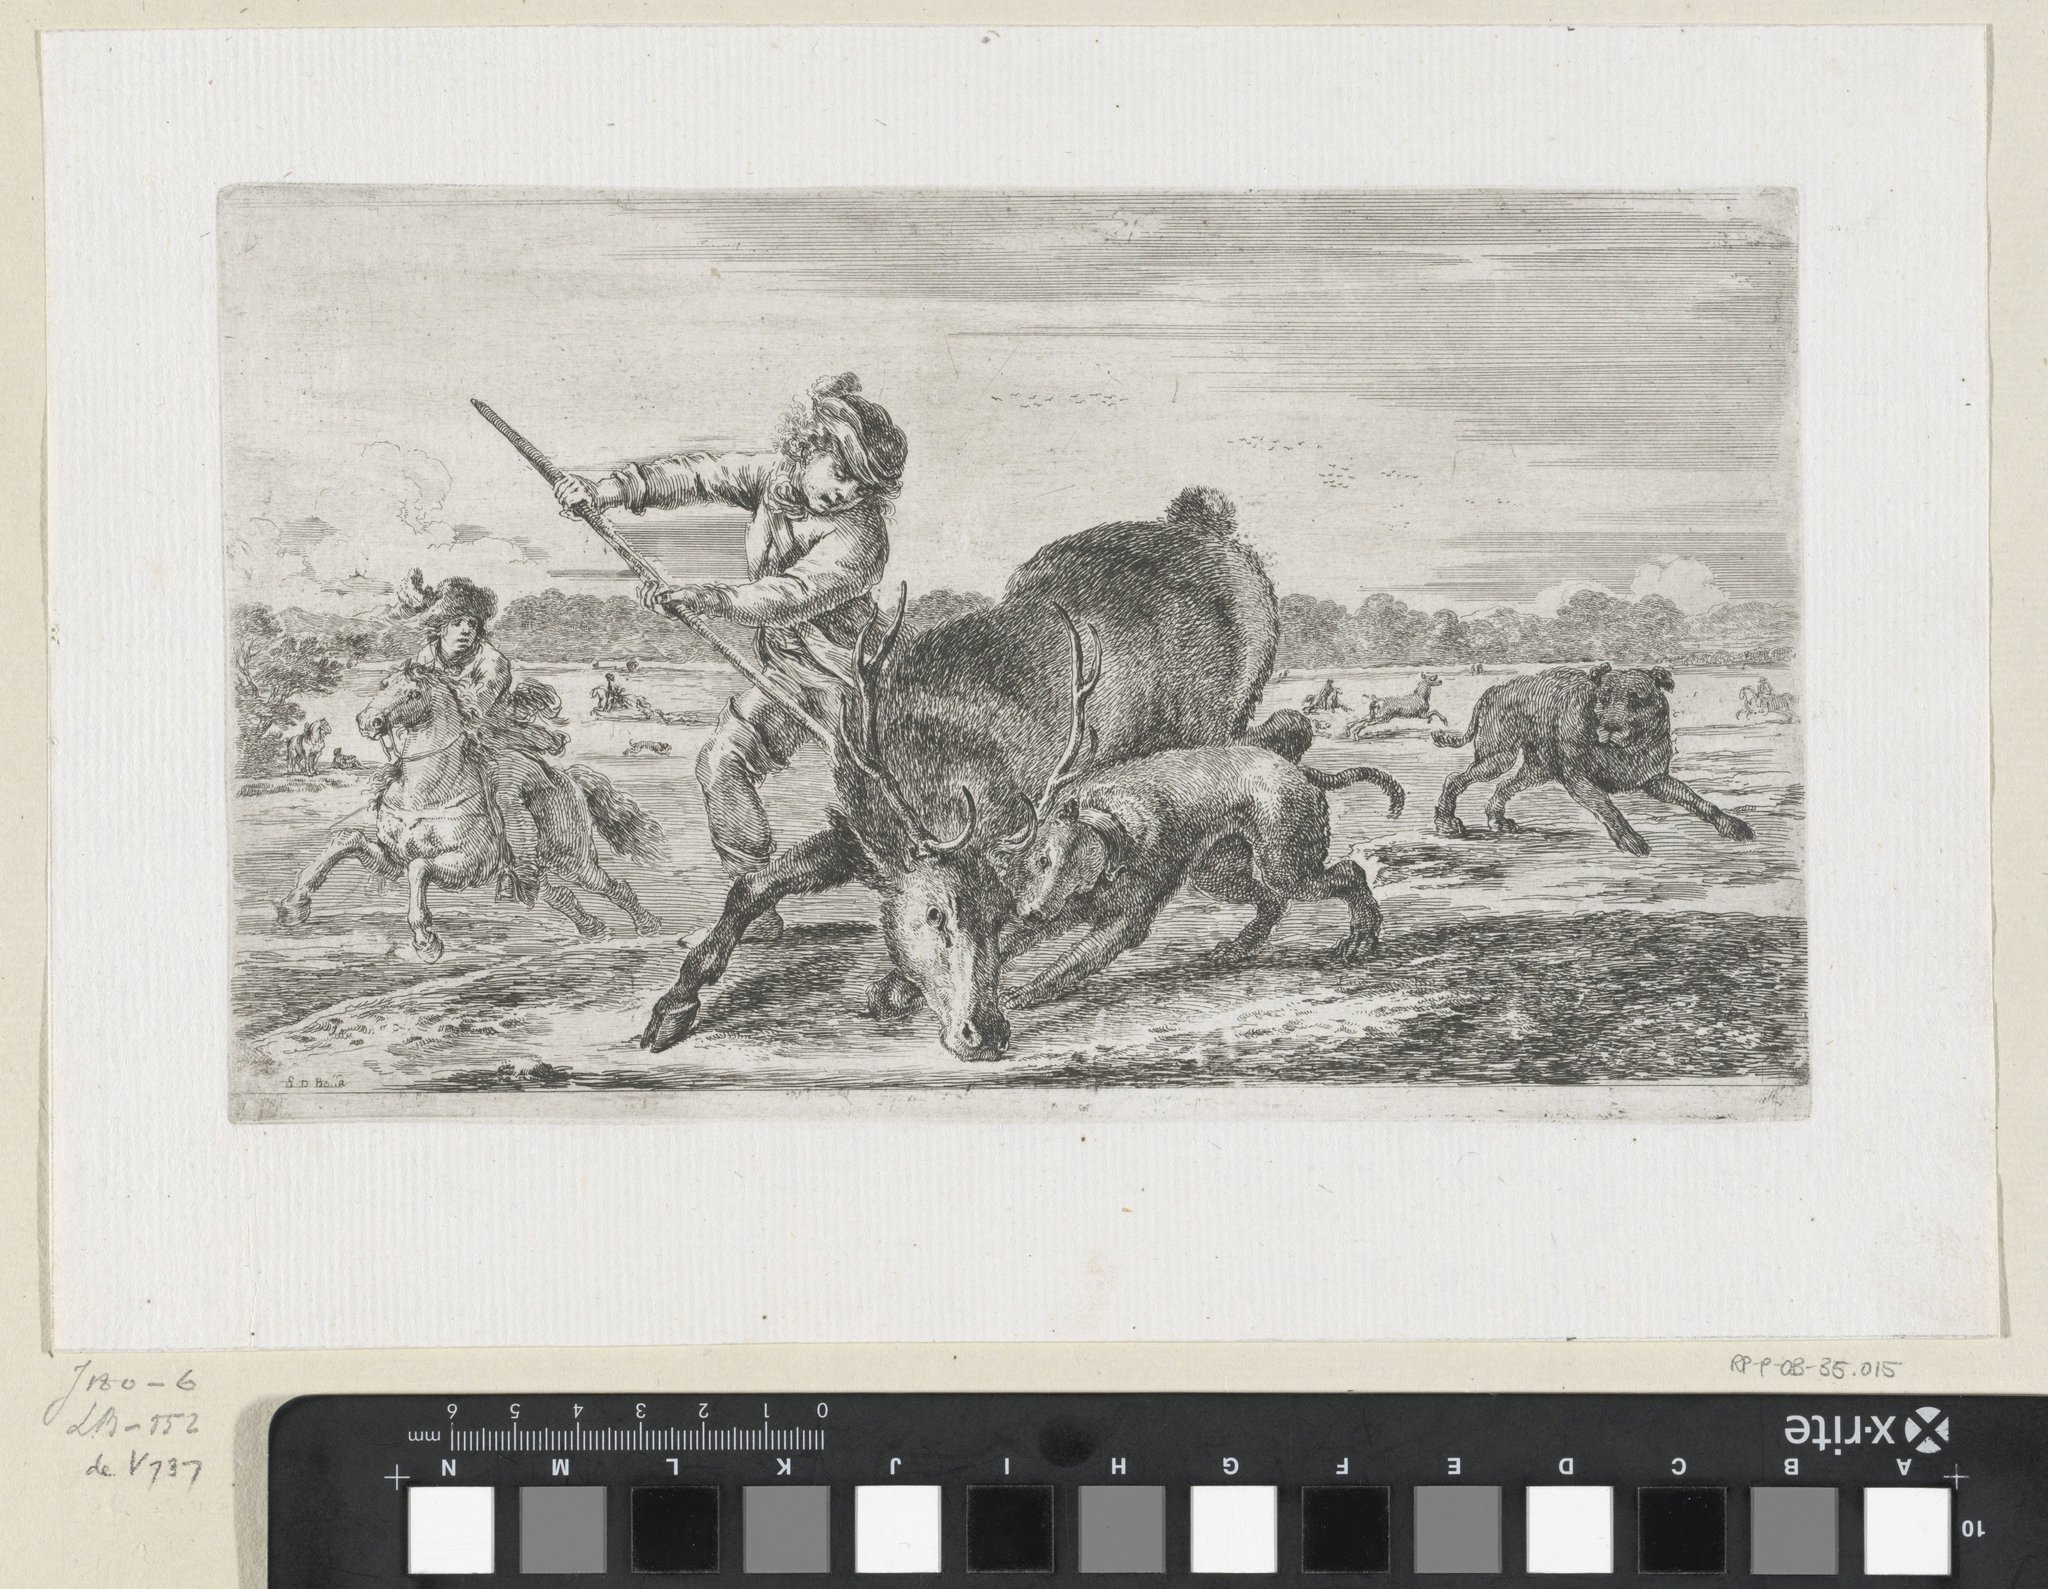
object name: print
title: Jachtscènes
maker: stefano della bella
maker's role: draughtsman, print maker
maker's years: 1610-1664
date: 1620-1664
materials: paper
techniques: etching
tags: hunting dogs, hunter, hoofed animals: stag, hunters hunting (n.b.: in 1988-1990 this notation denoted the concept of 43c11421 'hunters resting during the hunt')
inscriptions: collector's mark: Lugt 240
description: Een hert wordt gevangen door een jager en een jachthond. De jager steekt een speer in de zijde van het hert. Op de achtergrond andere jagers en honden op jacht.